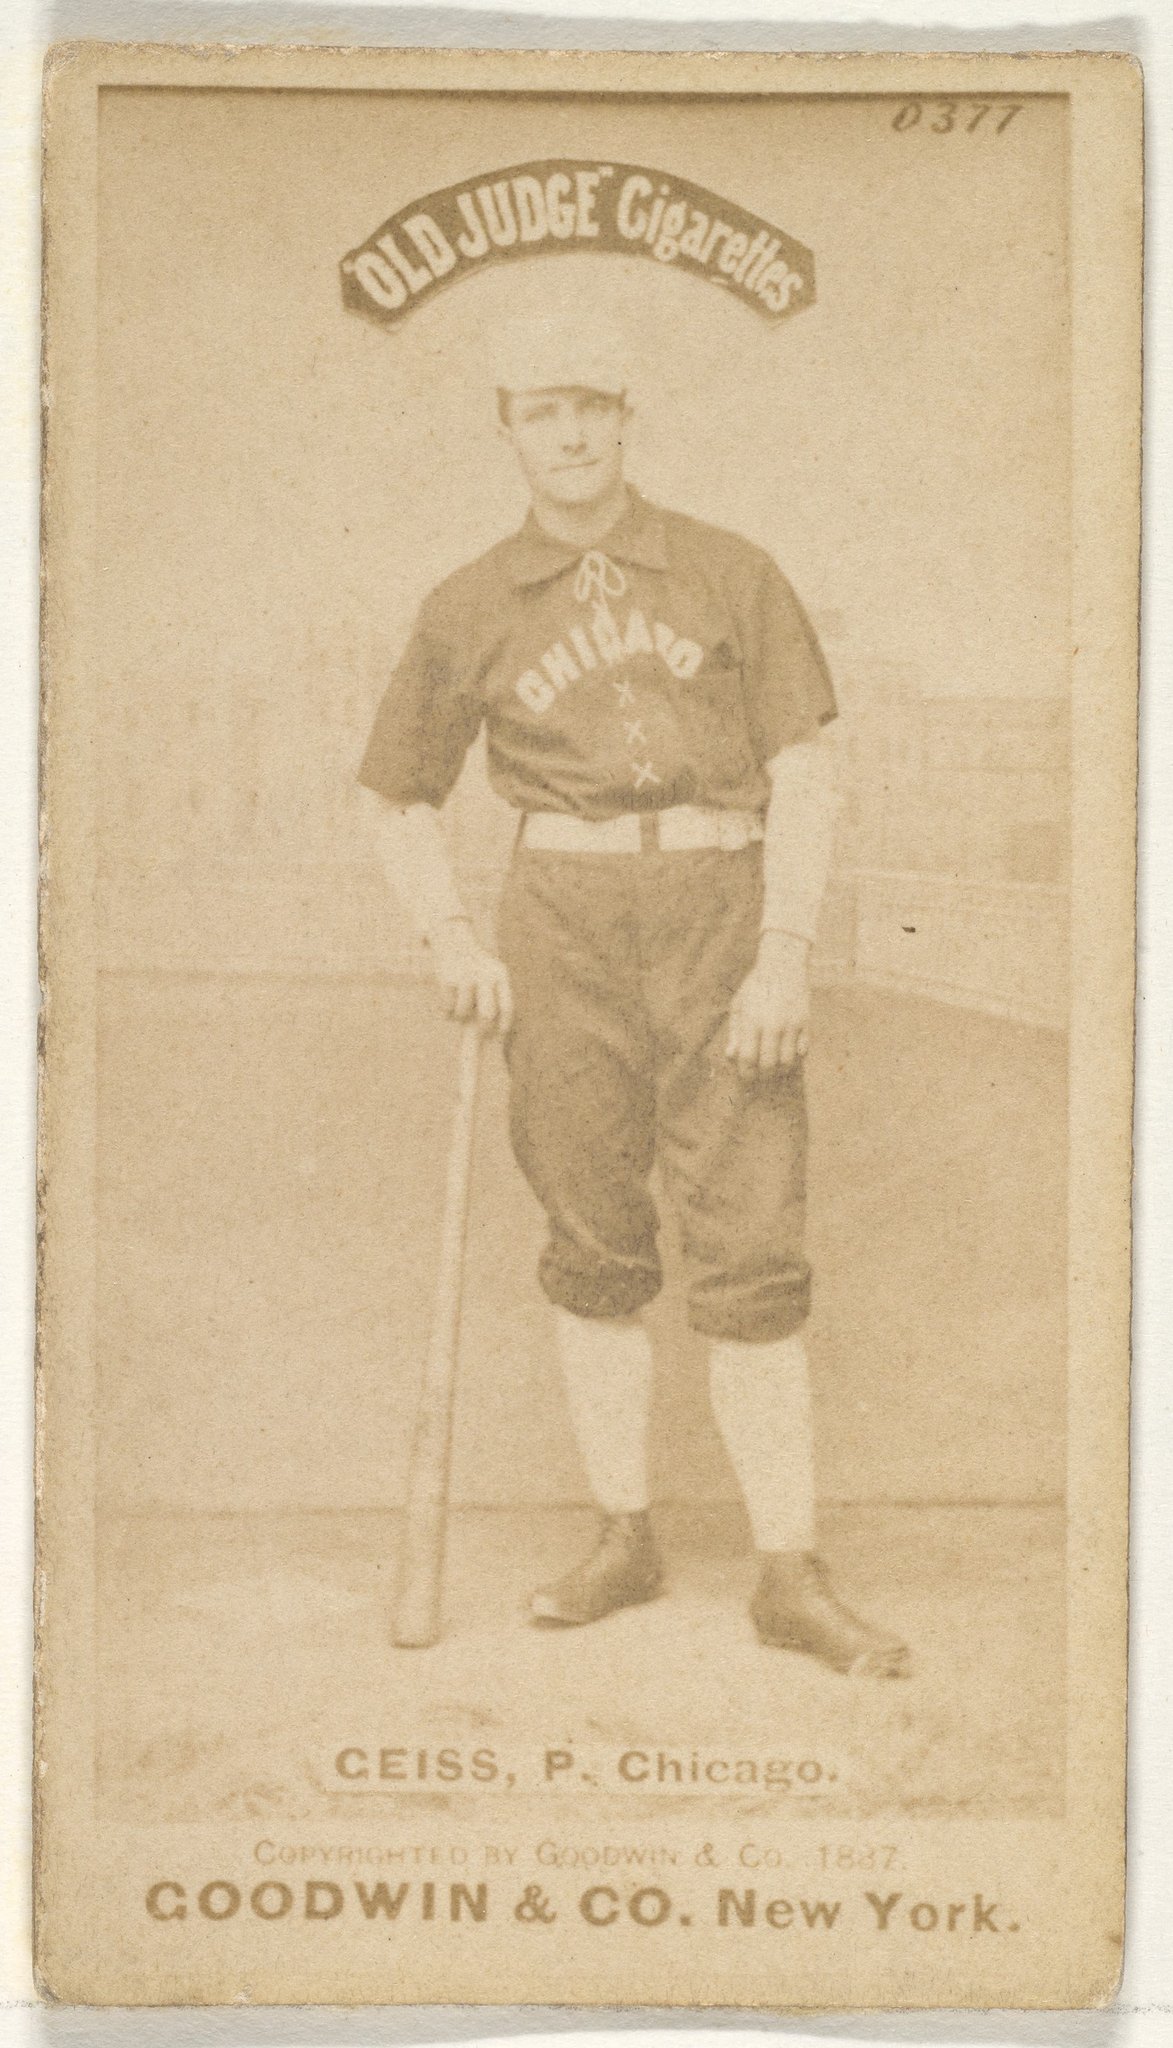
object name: baseball card, photograph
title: Ceiss, Pitcher, Chicago, from the Old Judge series (N172) for Old Judge Cigarettes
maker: goodwin & company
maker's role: publisher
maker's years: 1850-1950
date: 1887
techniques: albumen silver print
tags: men,portraits,baseball,athletes